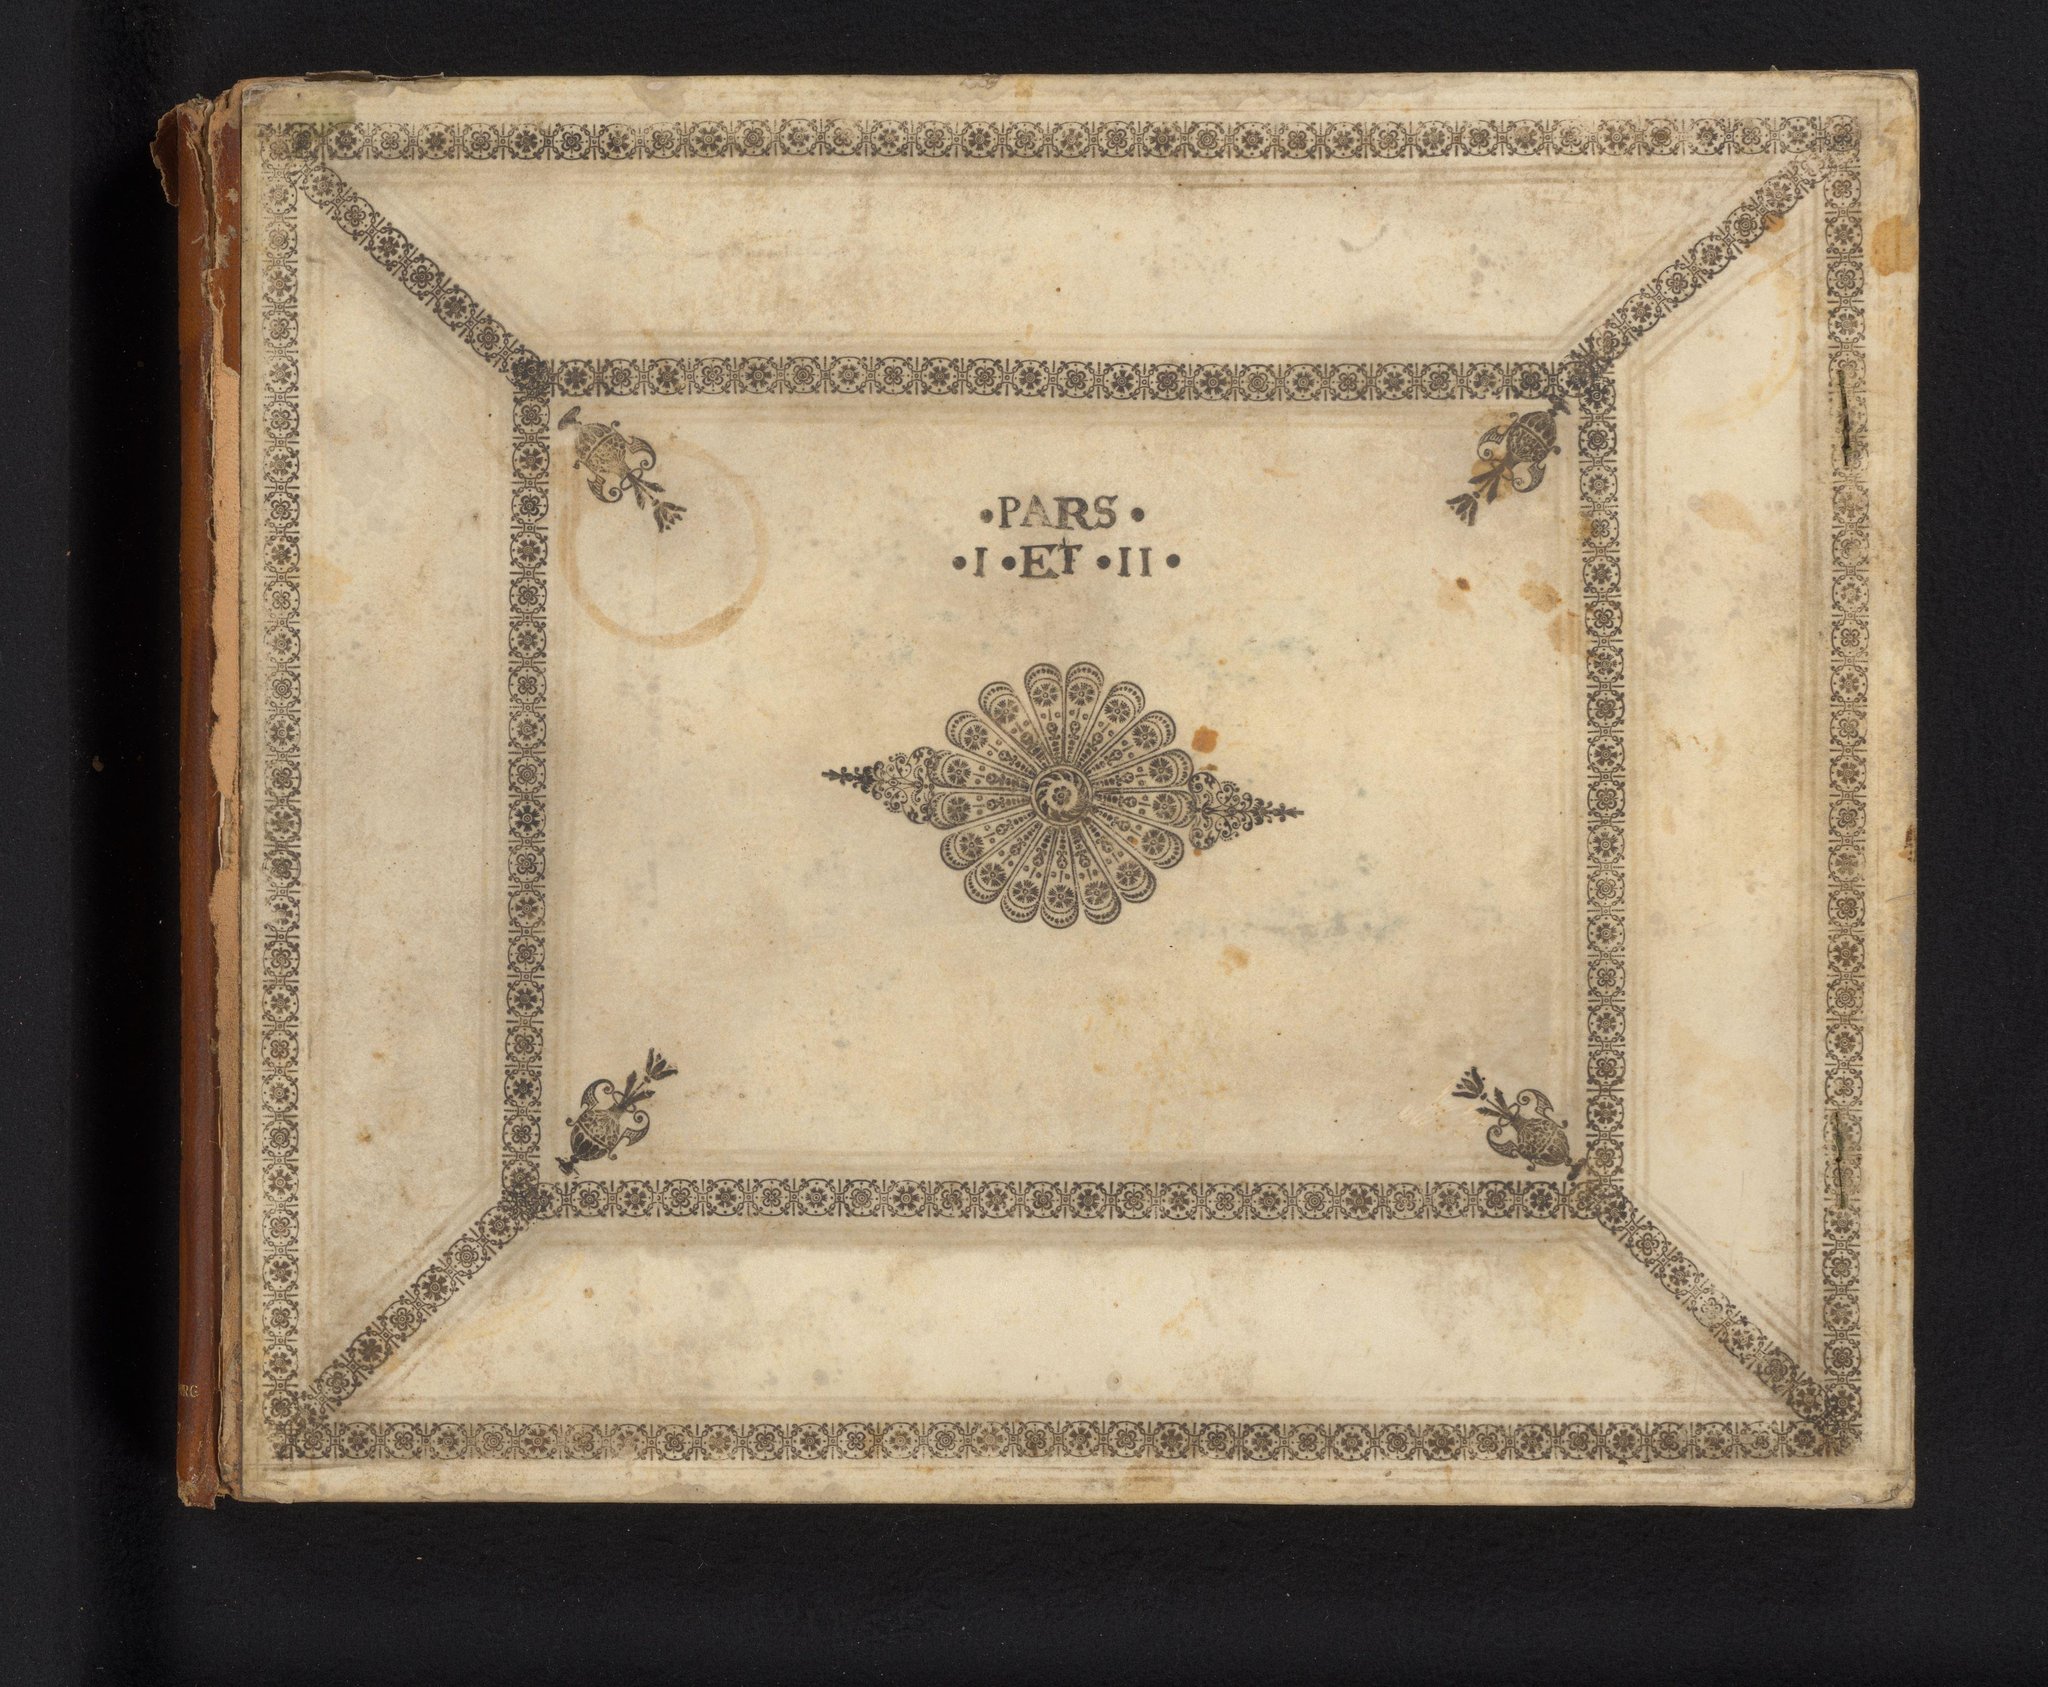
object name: prentrecueil, prentenalbum, prentalbum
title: Iconographia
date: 1670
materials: cardboard, leather, paper, parchment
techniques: bookbinding, etching, letterpress printing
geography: augsburg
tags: landscapes, good and bad behaviour, moral qualities, passion of christ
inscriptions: collector's mark: Lugt 2228, title: ‘Iconographia: pars I et II’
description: De volledige titel van deze band zoals vermeld op de titelprent luidt: Ioannis Guilielmi Baurn Iconographia complectens in se Passionem, Miracula, Vitam Christi Universam, nec non Prospectus rarissimorum portuum, palatiorum, hortorum, historiarum, aliarumq rerum, quae, per Italiam, spectatu sunt dignae, proprio aere aeri incisae et venales expositae, a Melchiore Kysell Augustano Augustae Vindelicorum anno Christiano MDCLXXXII. Op de zijkant van het album, bij de titel, staat foutief gedrukt dat het deel drie en vier betreft (Augsburg 1682 | Iconographia | I. G. Baur | III - IV) terwijl dit album deel één en twee omvat. Het album heeft twee ex librissen van Sir William Sitrling Maxwell op de dekbladen.